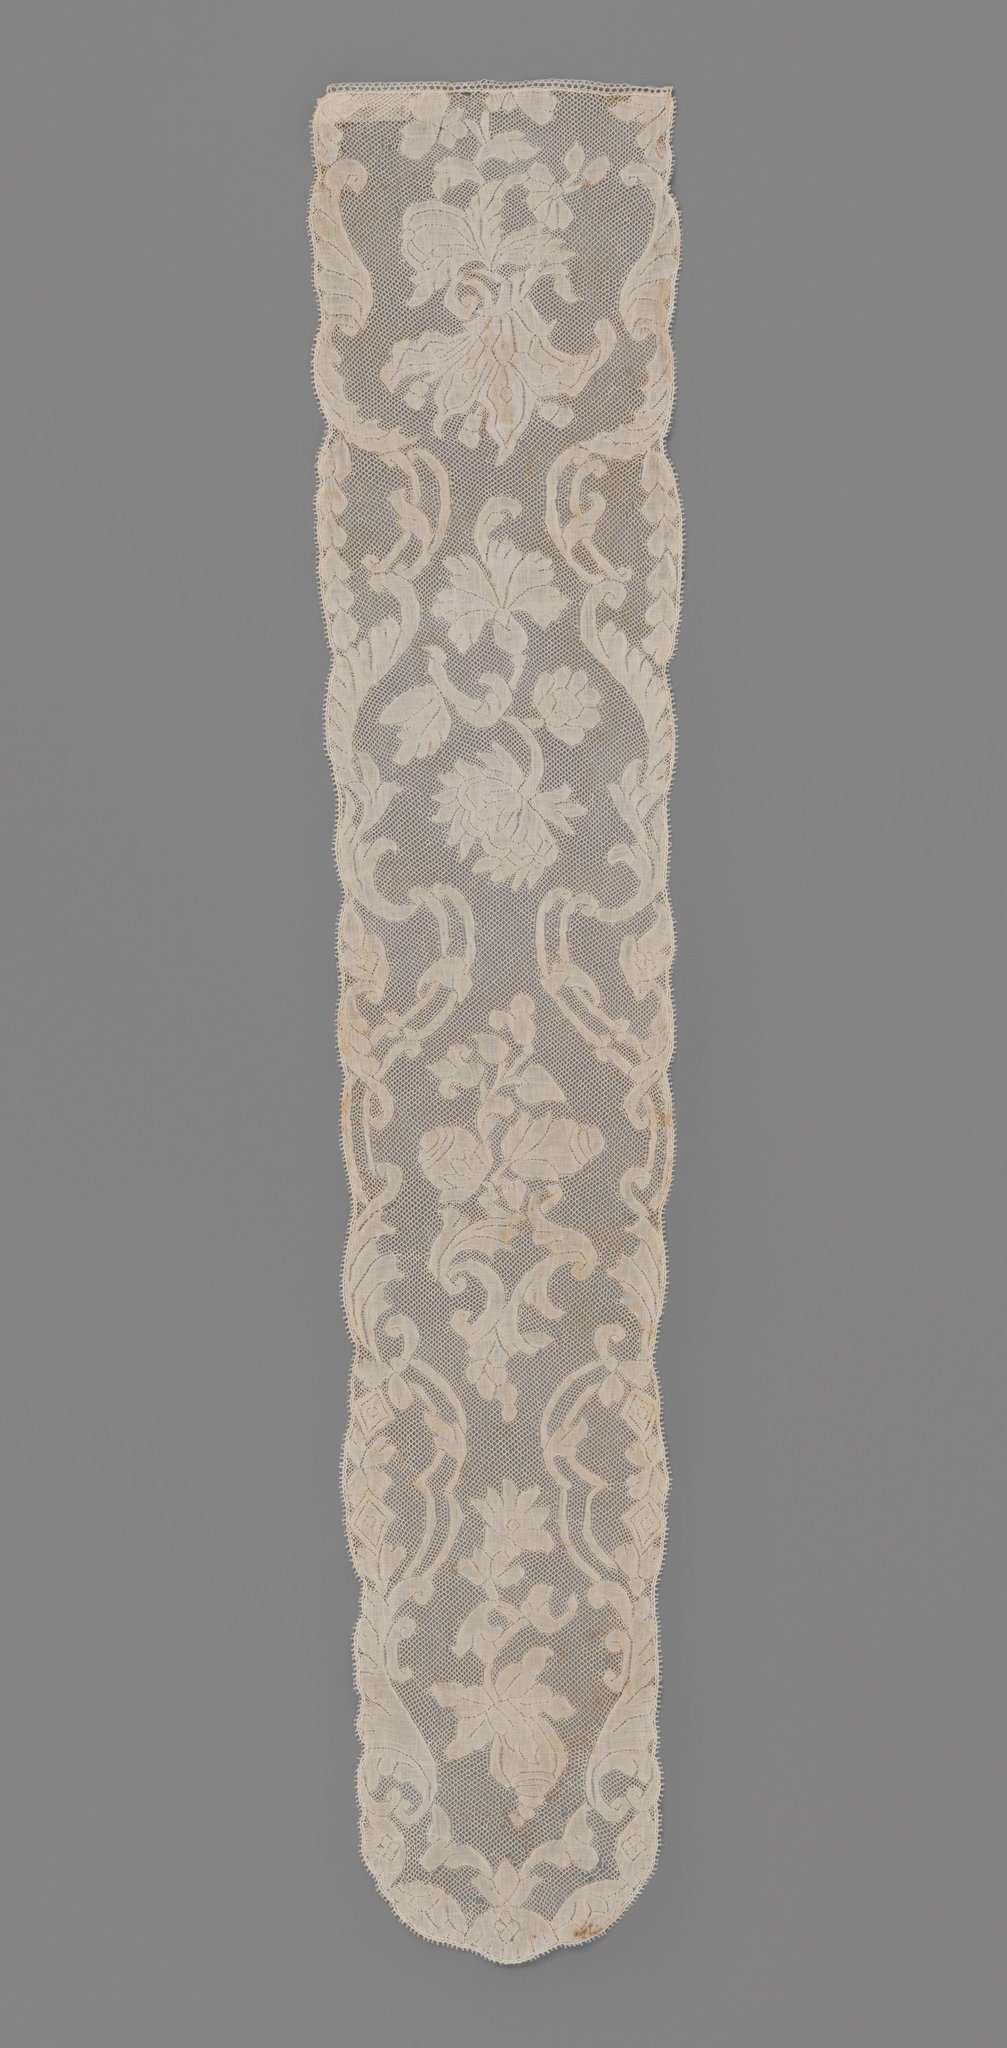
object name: womenswear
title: Mutsenslip (barbe) van Valenciennes-kant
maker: Anonymous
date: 1700-1750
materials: linen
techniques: lace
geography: france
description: Barbe van Valenciennes-kant. Het patroon heeft bloemen en ranken op een grond van ruitvormige mazen. De schulprand is afgezet met picots.